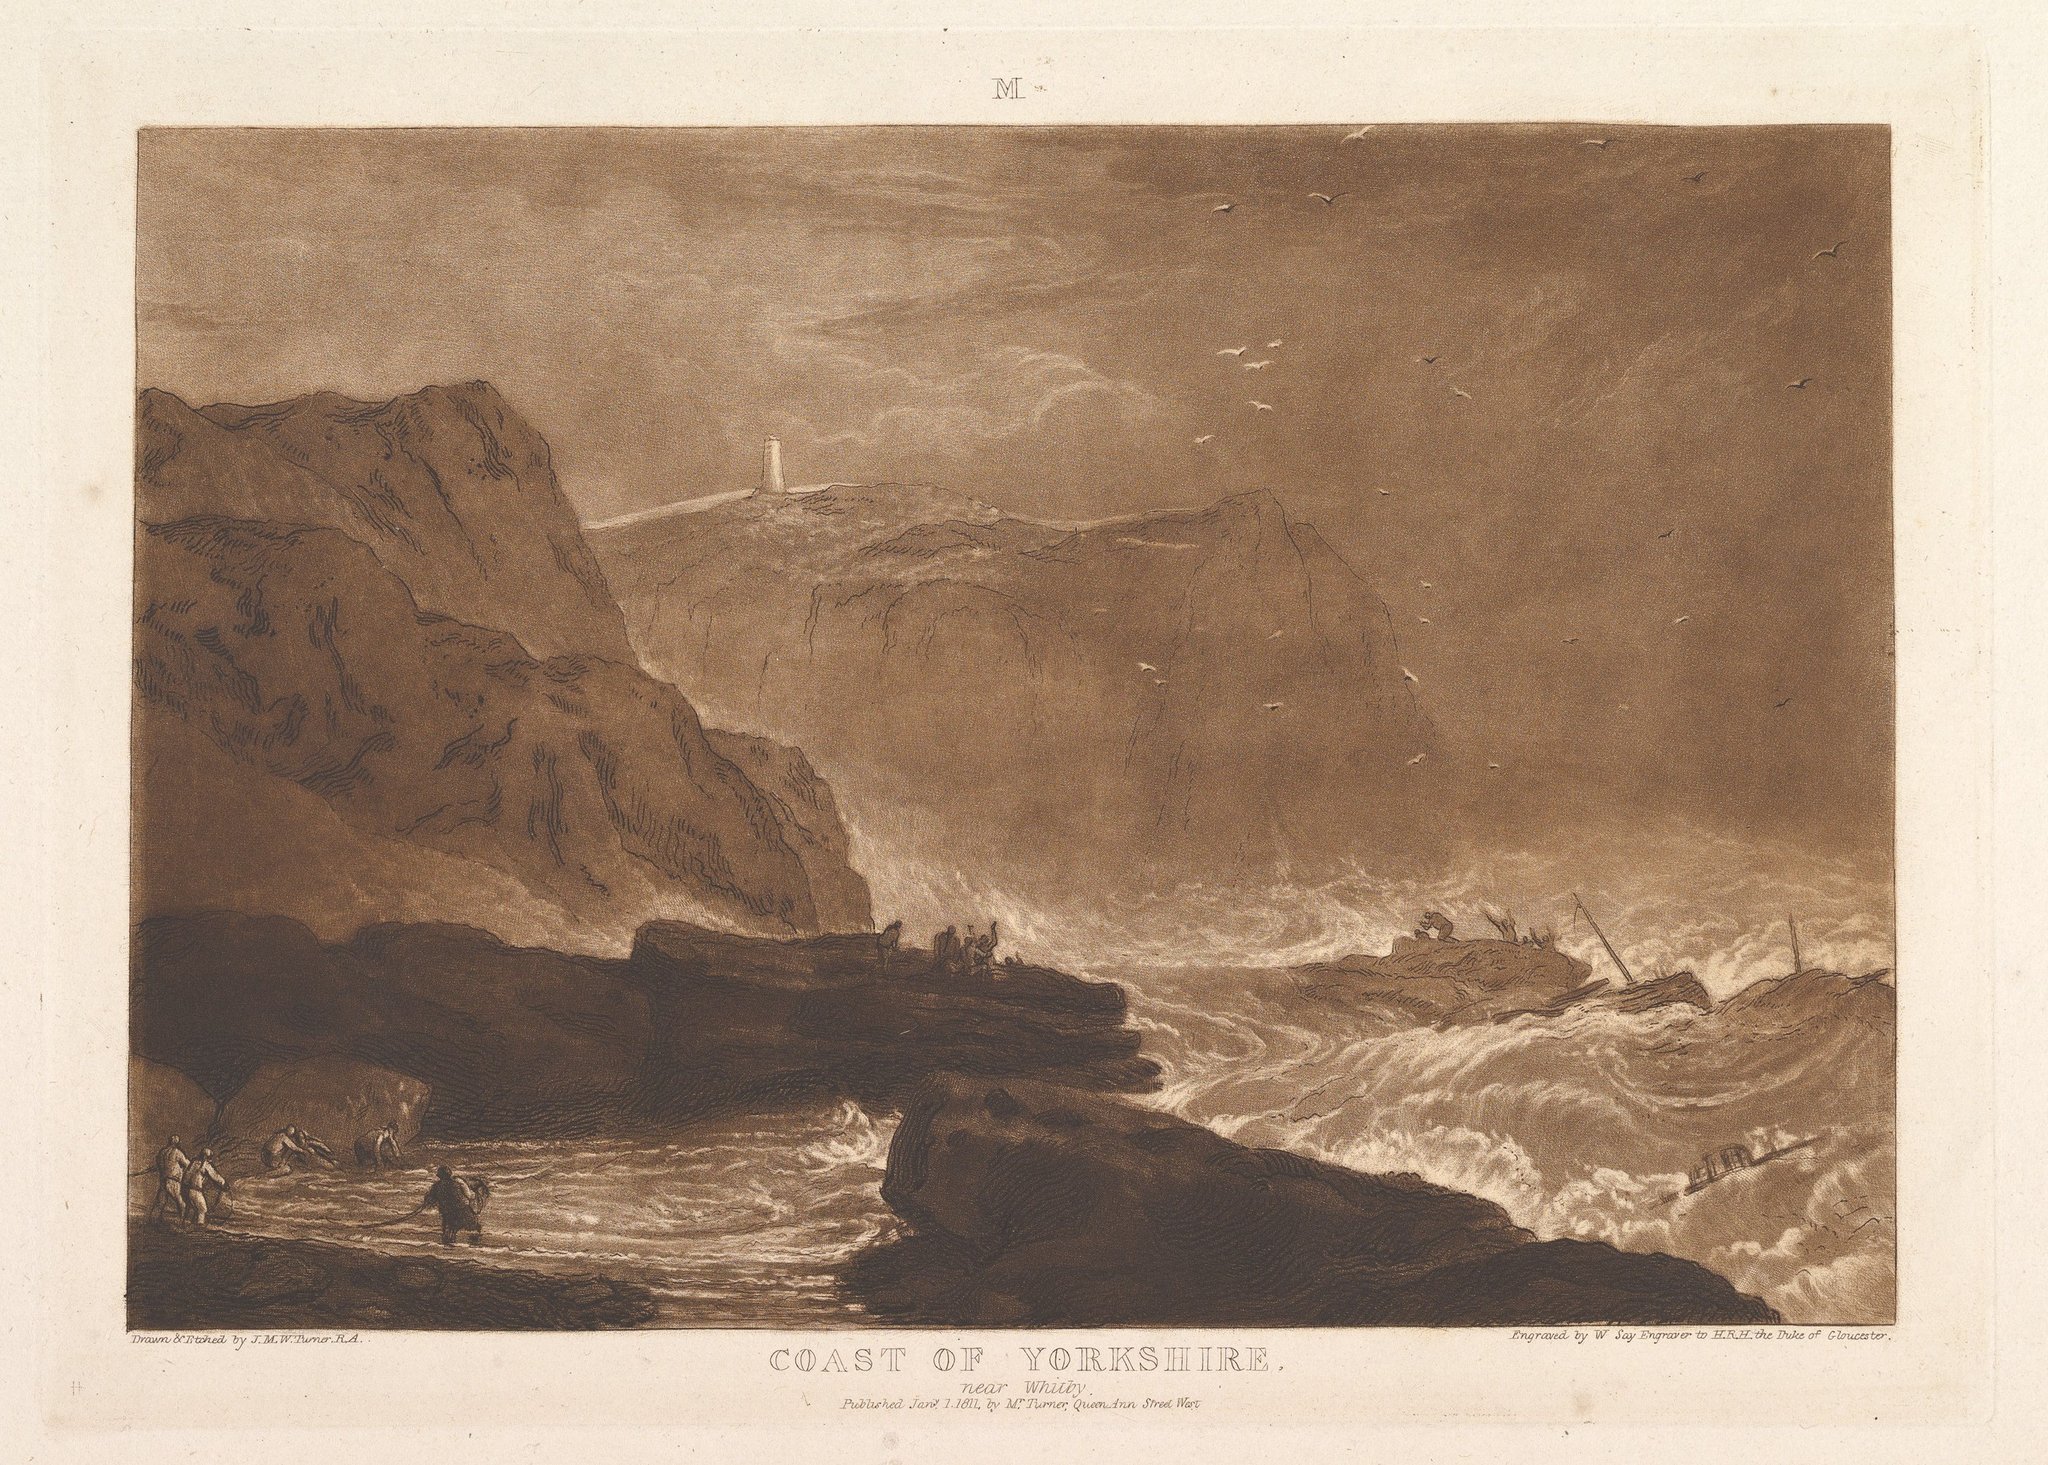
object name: print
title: Coast of Yorkshire, Near Whitby (Liber Studiorum, part V, plate 24)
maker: joseph mallord william turner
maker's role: artist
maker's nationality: british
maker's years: 1775-1851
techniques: etching, mezzotint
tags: landscapes,waves